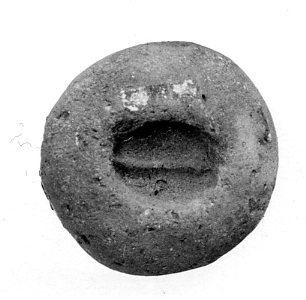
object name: mold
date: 1550-1295 BCE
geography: egypt